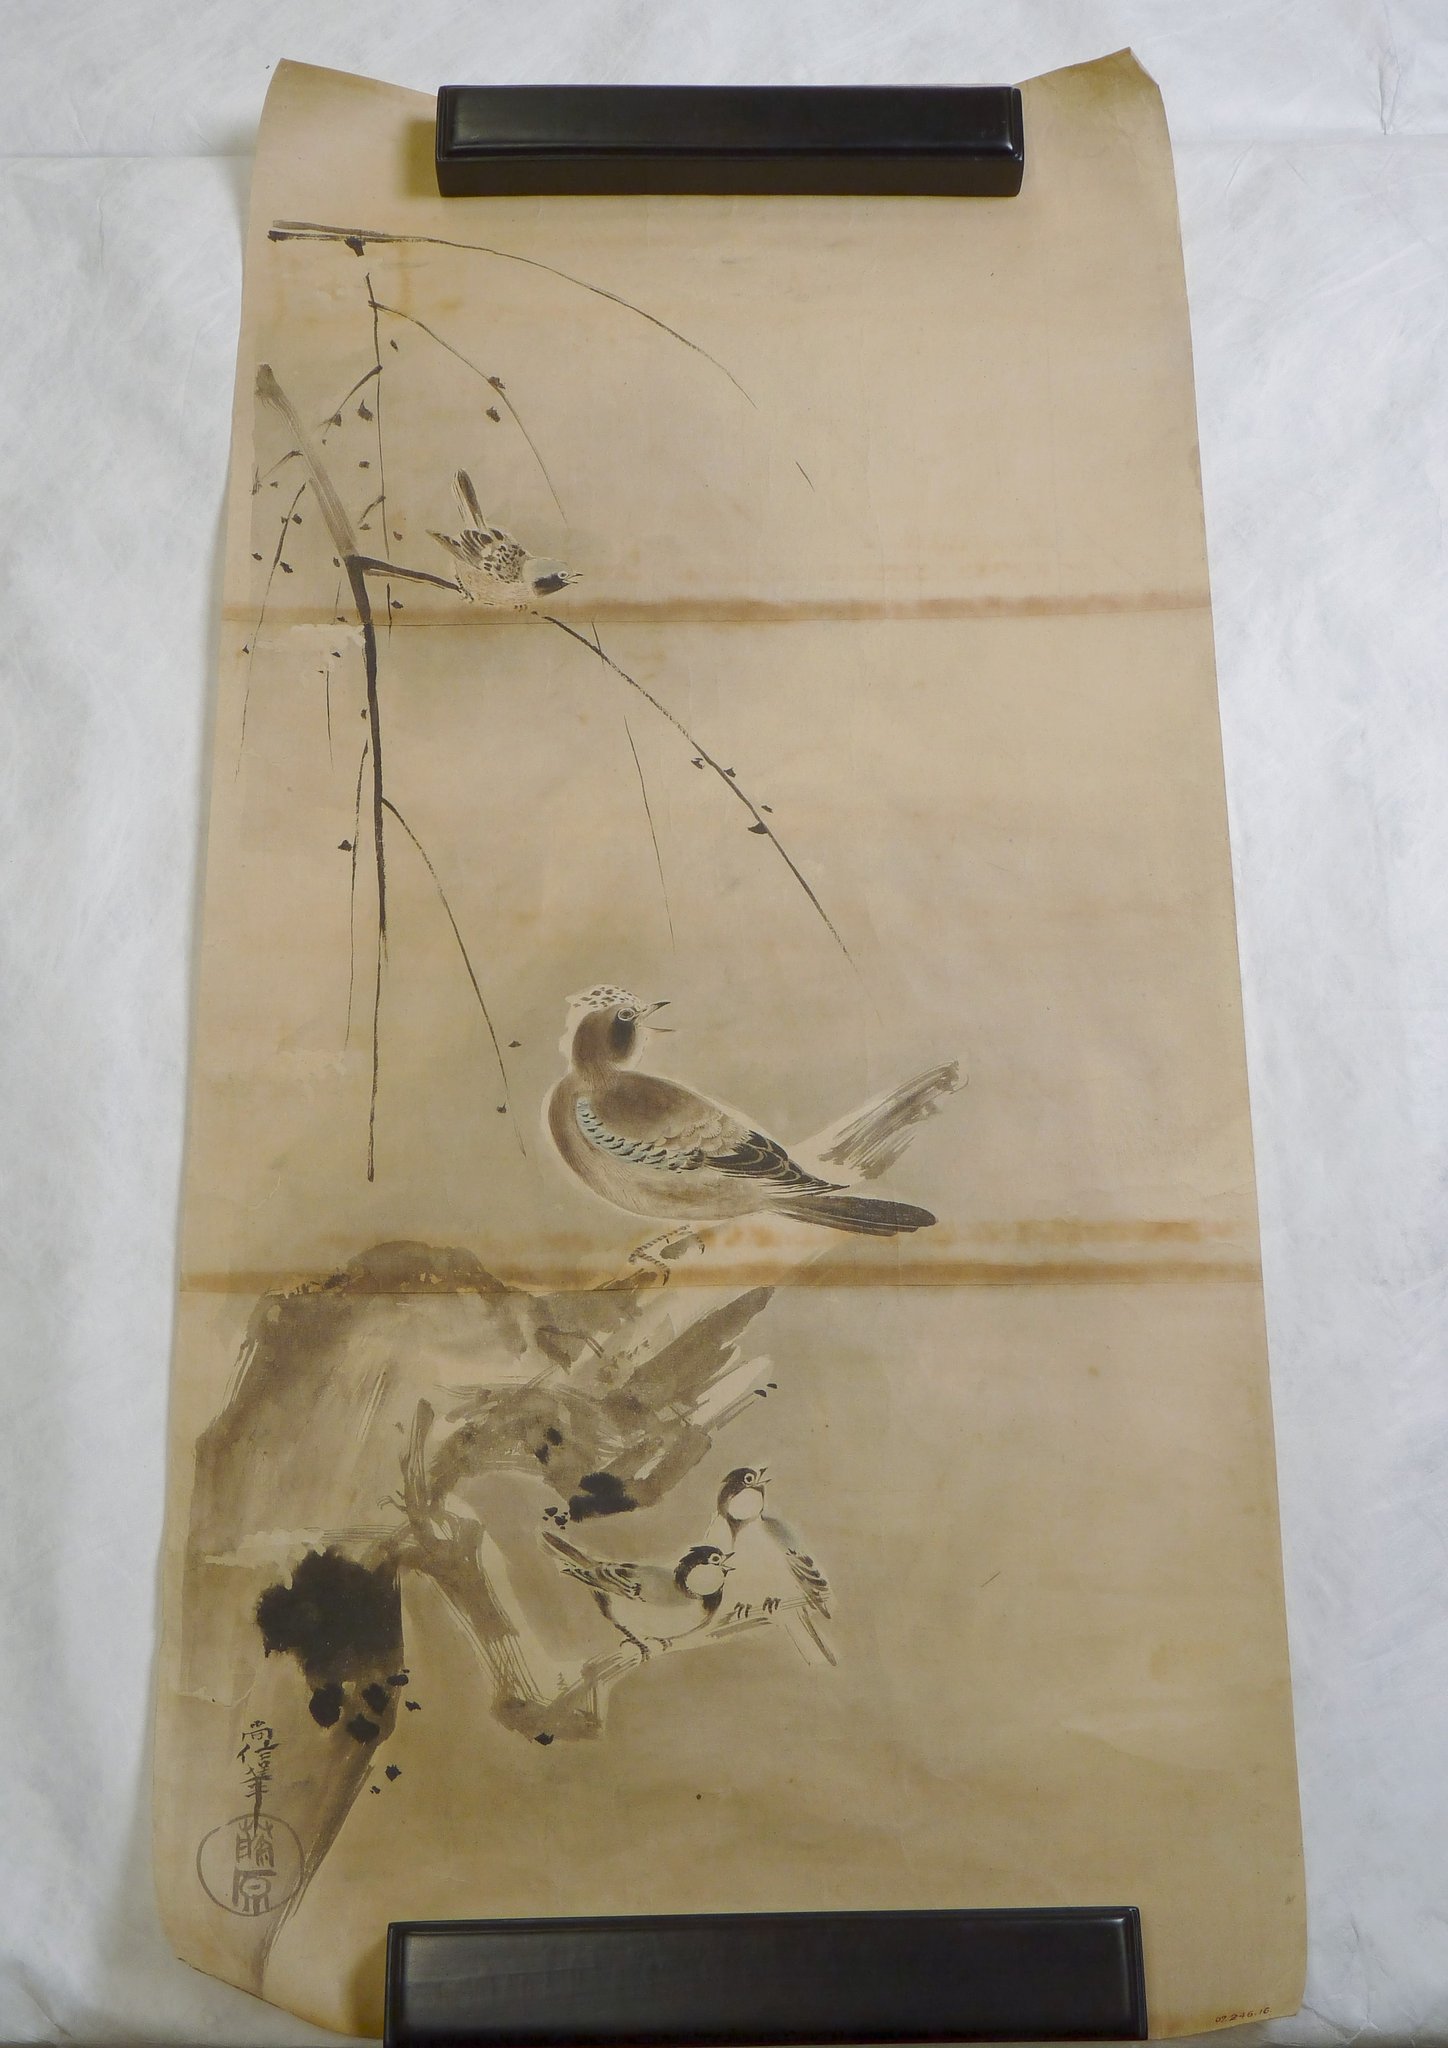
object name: drawing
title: Japanese Drawing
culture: japanese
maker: kano naonobu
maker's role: artist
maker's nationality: japanese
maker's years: 1607-1650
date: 1801-1833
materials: paper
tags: birds